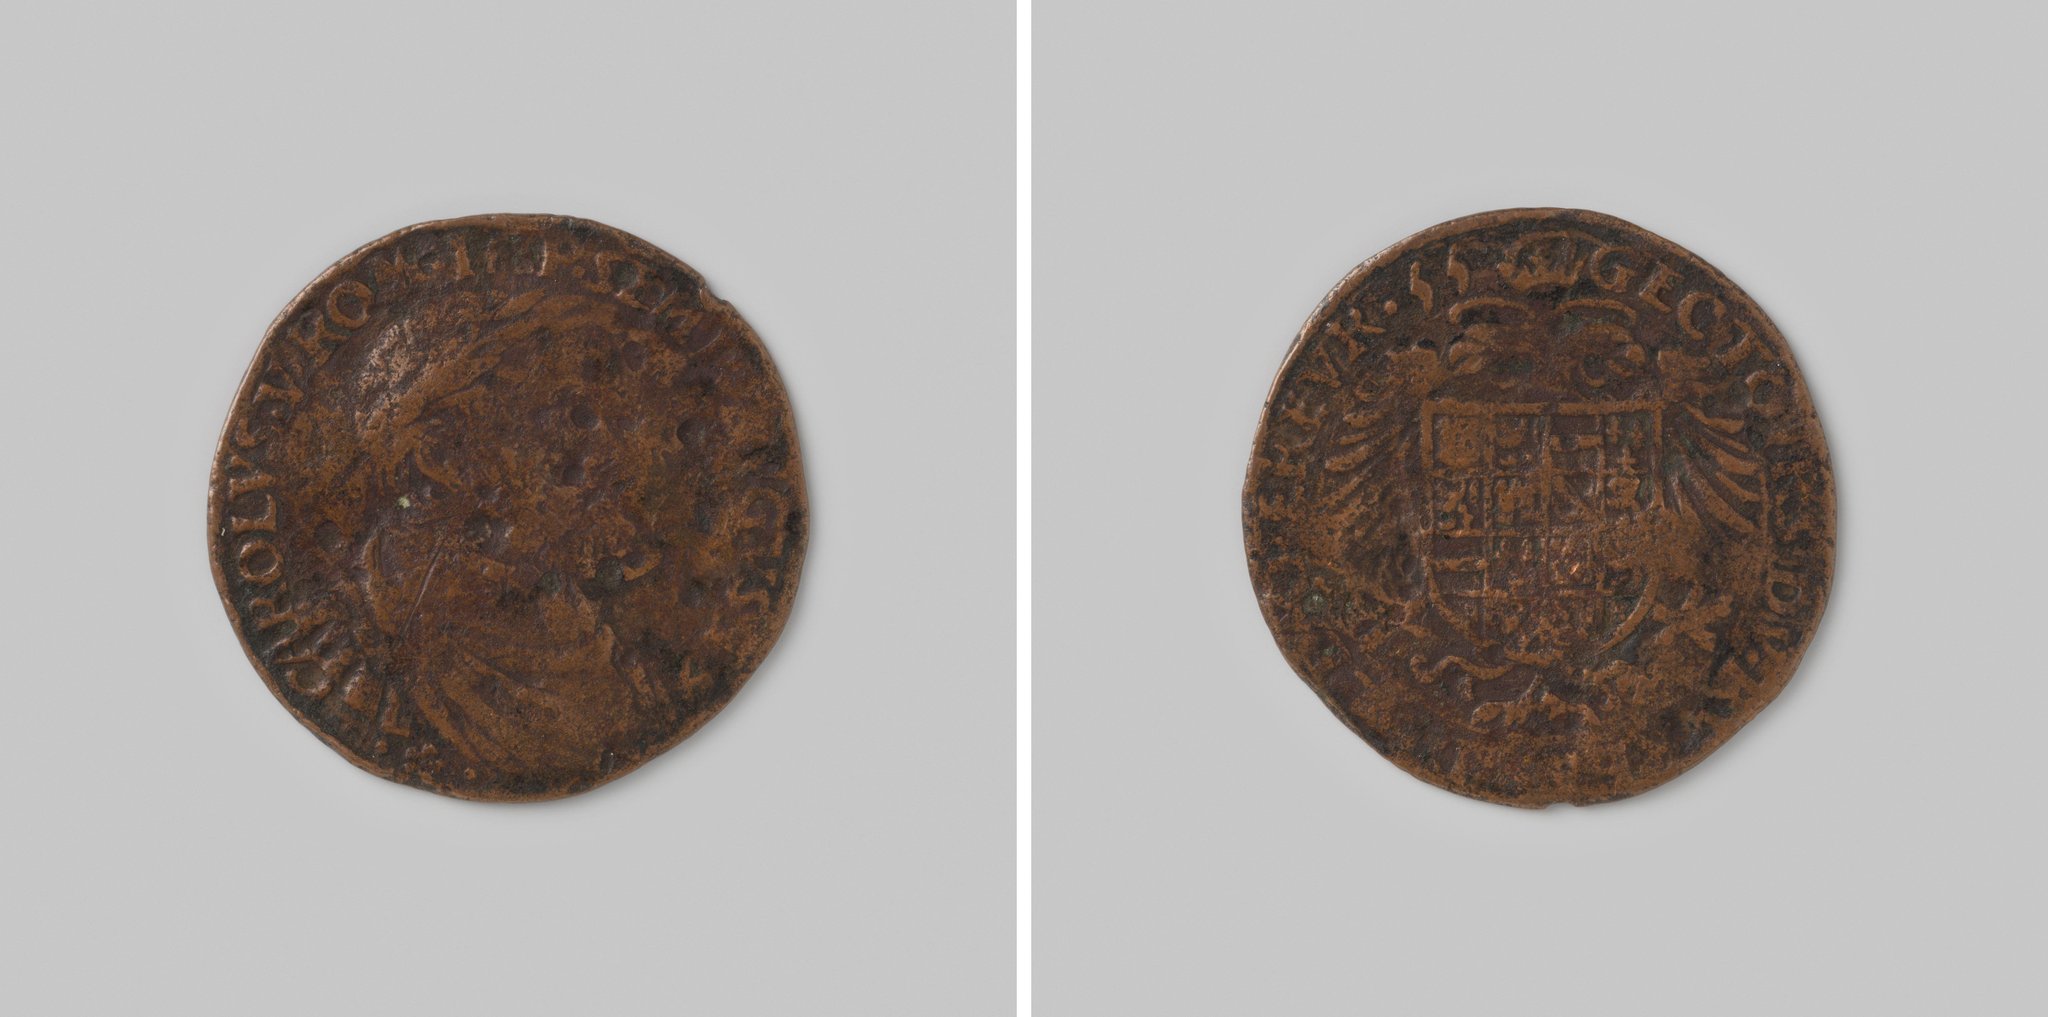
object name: history medal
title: Rekenpenning uit Dordrecht voor het bureau van de keizer 1555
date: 1555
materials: copper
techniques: striking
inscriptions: circumscription: ‘GECTOIRS DV BVREAV DE L EMPEREVR 55’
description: Koperen penning, op de voorzijde het borstbeeld van Karel V naar rechts met omschrift, op de keerzijde het Spaanse wapen op een gekroonde dubbelkoppige adelaar, met omschrift.